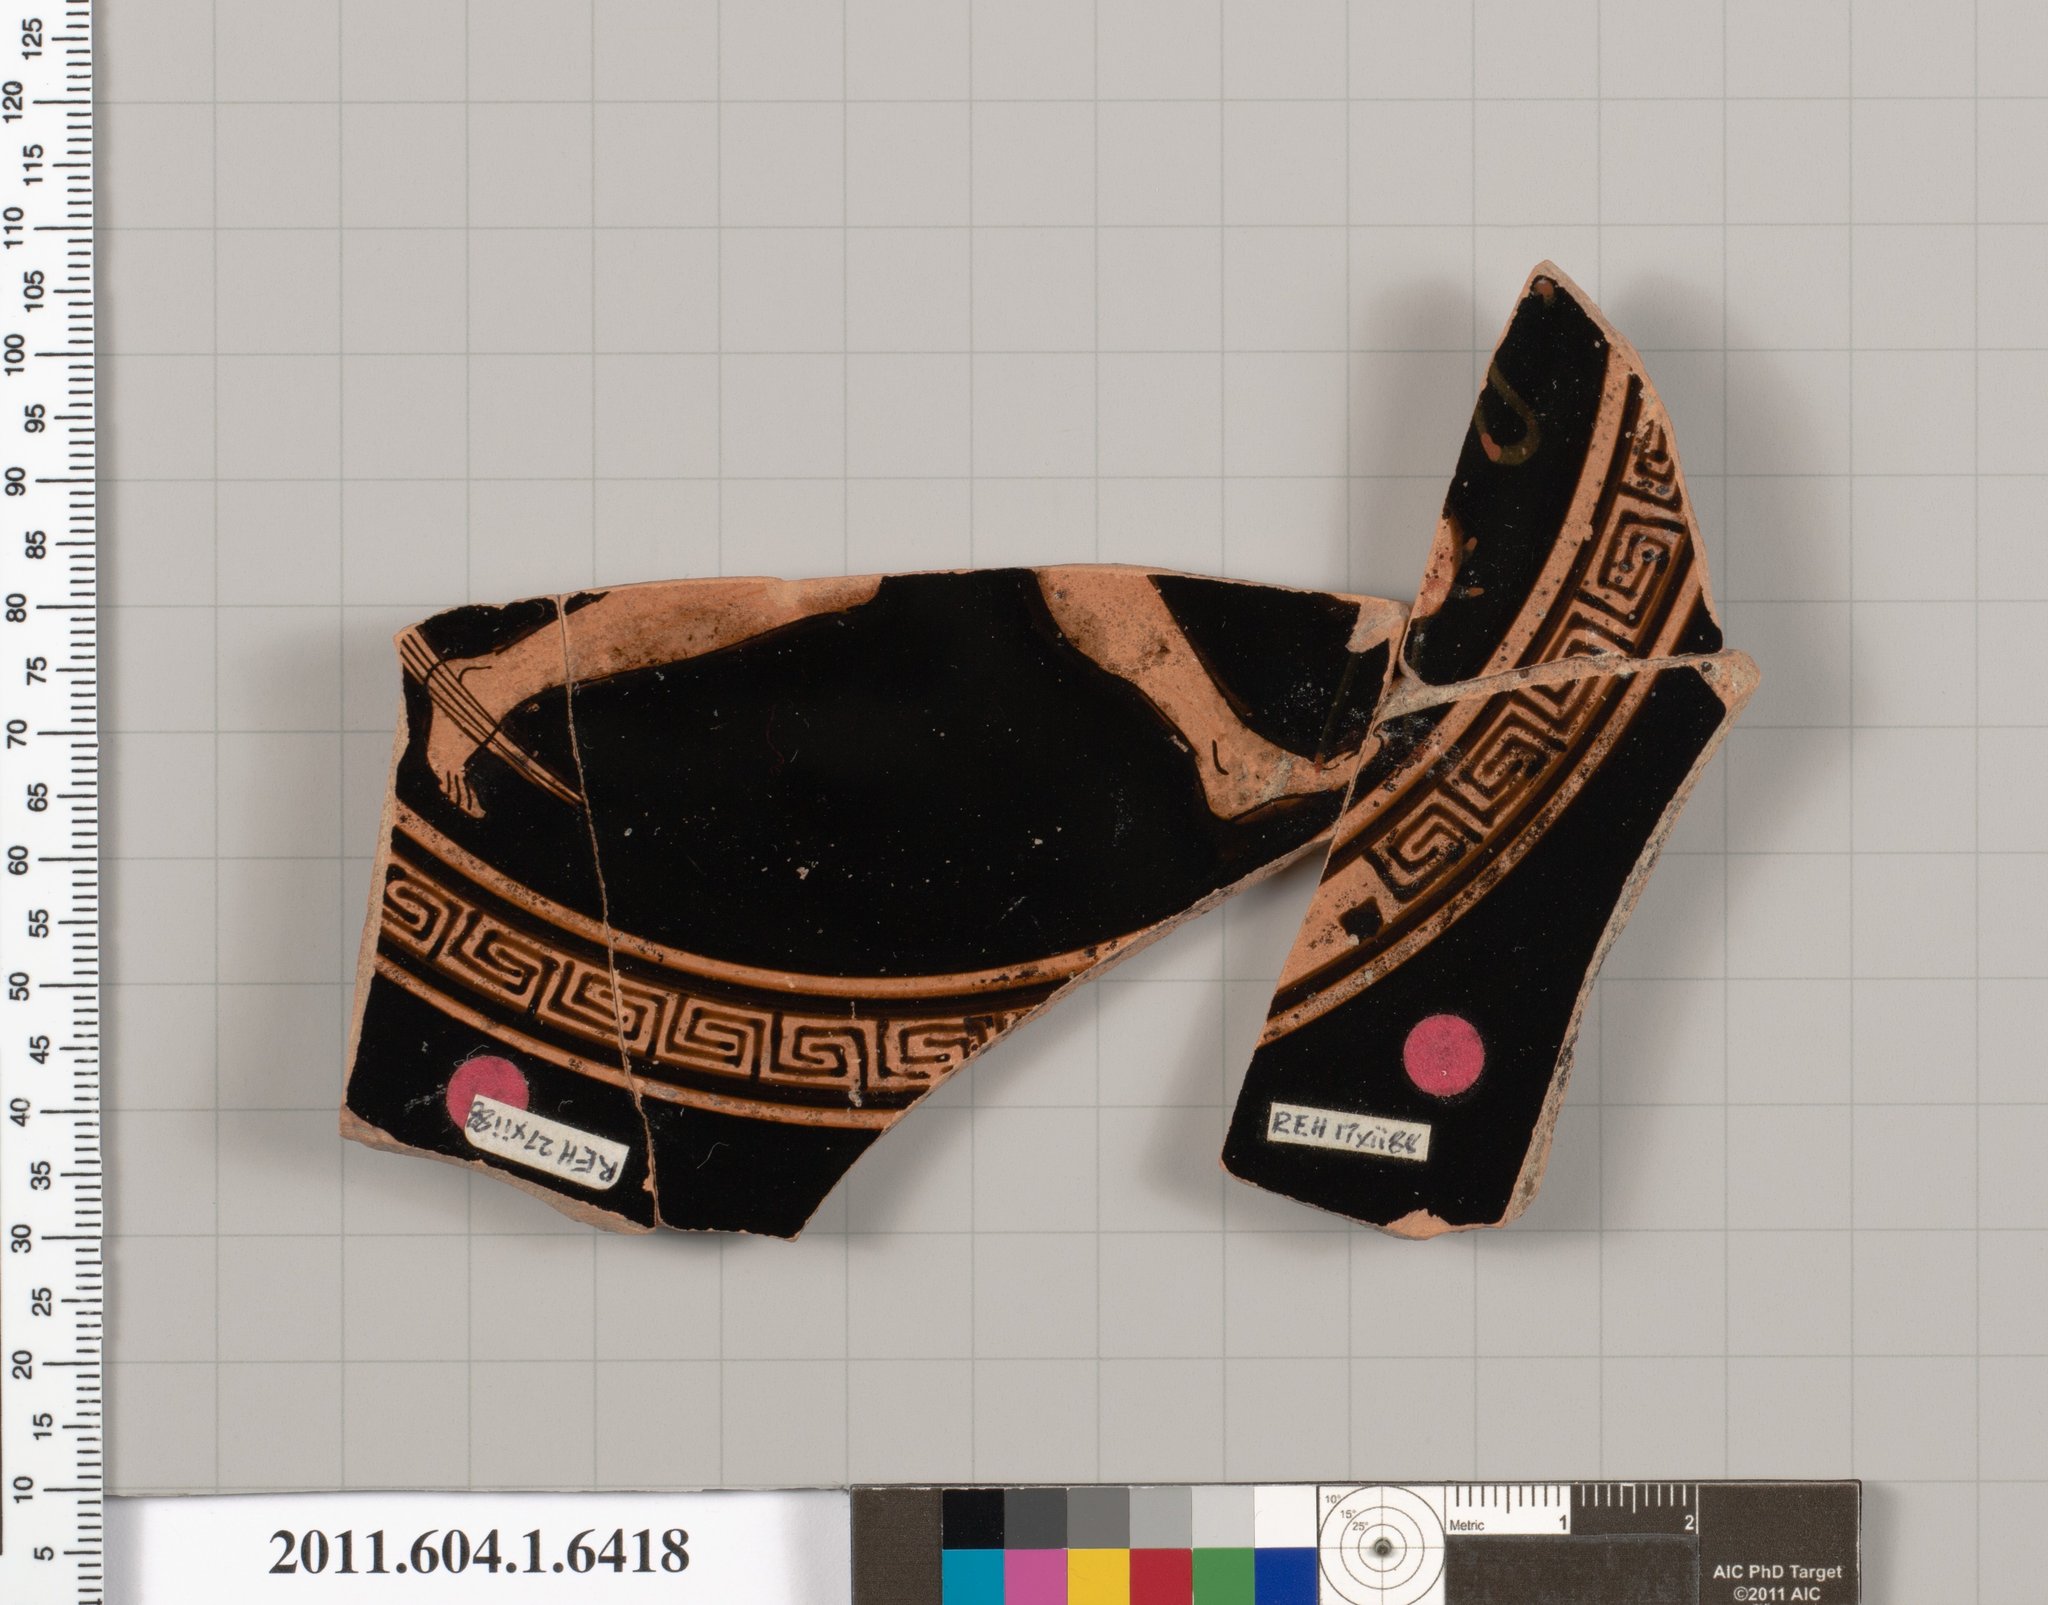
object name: kylix fragment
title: Terracotta fragment of a kylix (drinking cup)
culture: greek, attic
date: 490-480 BCE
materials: terracotta